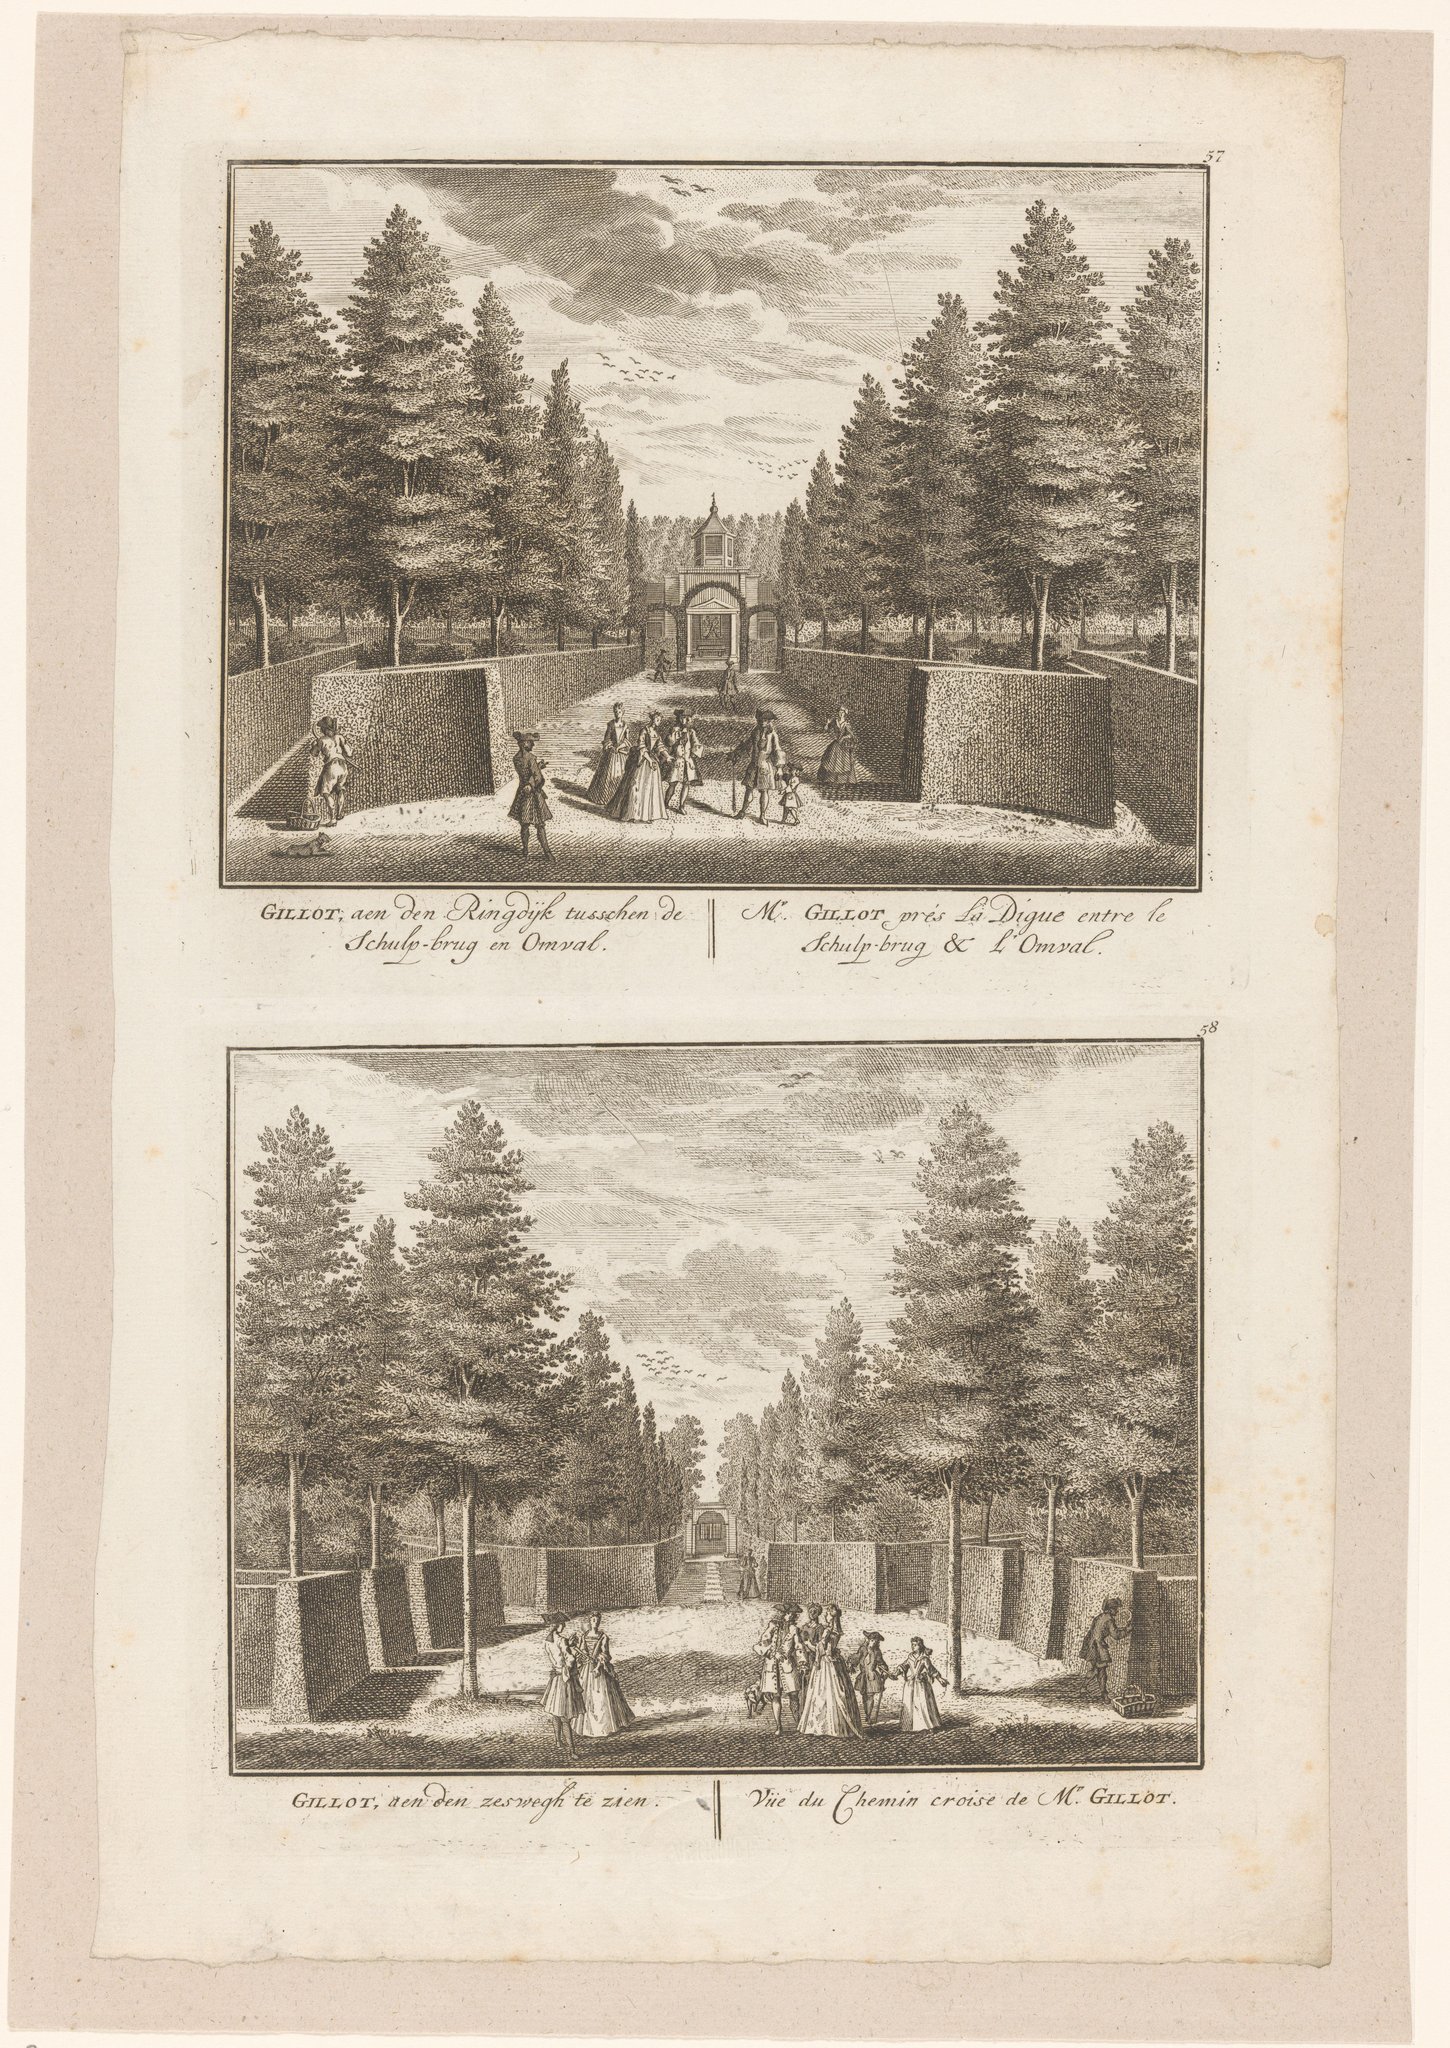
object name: print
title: Twee gezichten op buitenplaats De Vergulde Eenhoorn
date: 1725-1768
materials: paper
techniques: engraving, etching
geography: amsterdam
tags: french or architectonic garden; formal garden, gardening, country-house, amsterdam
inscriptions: check stamp: ‘Archief Ministerie van Oorlog Afdeeling Genie’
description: Boven een gezicht op buitenplaats De Vergulde Eenhoorn, links een tuinman die de heg bewerkt. Rechtsboven genummerd: 57. Onder een gezicht op de zessprong bij buitenplaats De Vergulde Eenhoorn, rechts een tuinman aan het werk. Rechtsboven genummerd: 58. Onder beide prenten een Nederlandse en Franse titel.